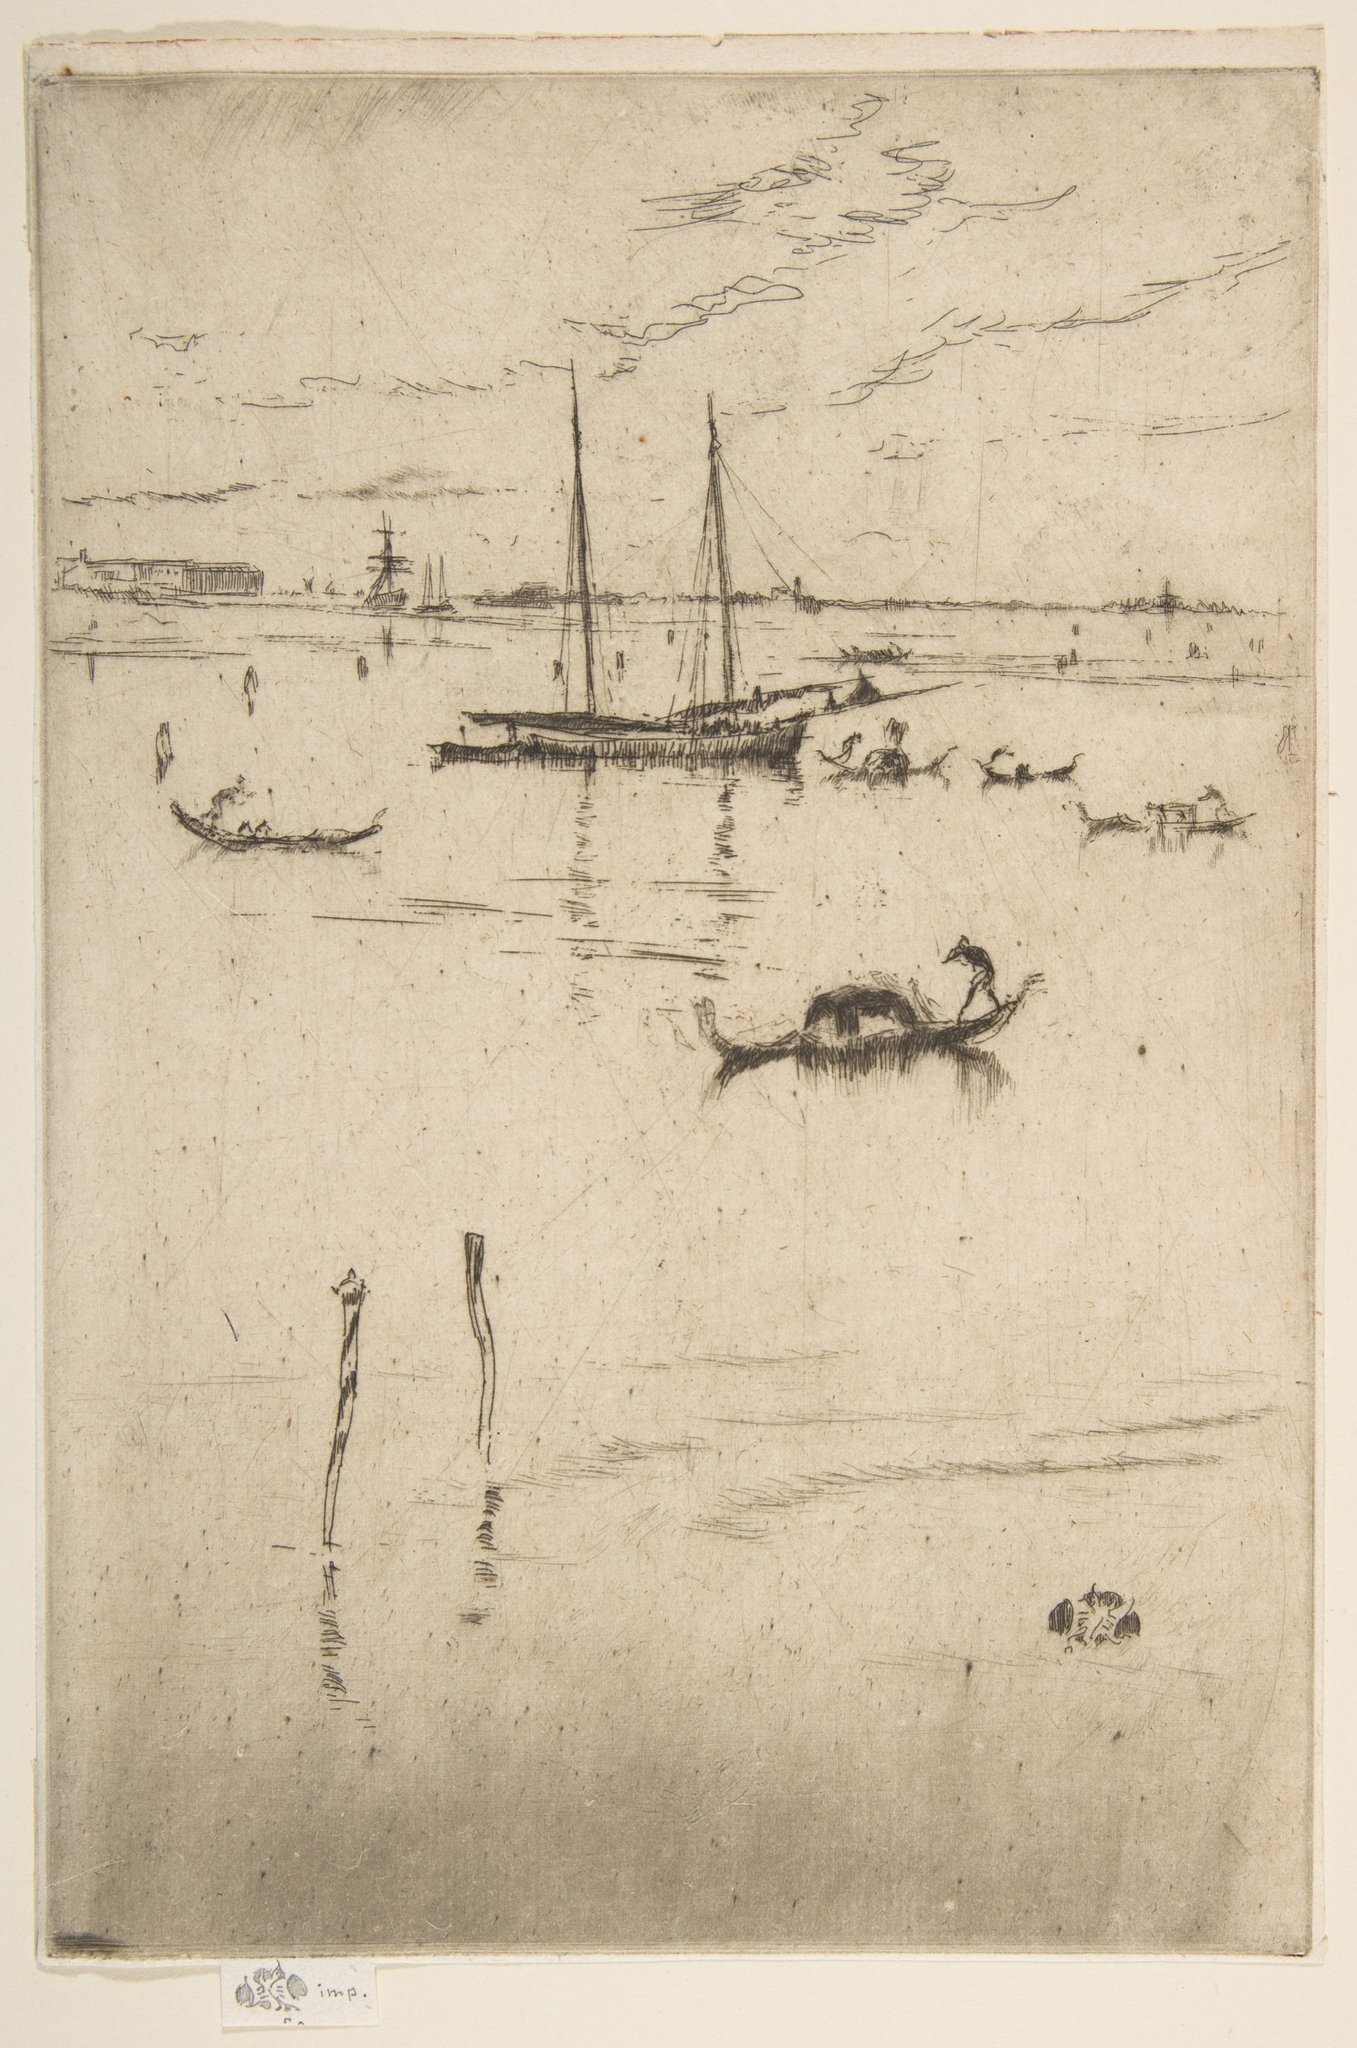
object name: print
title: The Little Lagoon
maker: james mcneill whistler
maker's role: artist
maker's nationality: american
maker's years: 1834-1903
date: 1879-1880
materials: ink, paper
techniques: drypoint, etching, printing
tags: boats,venice